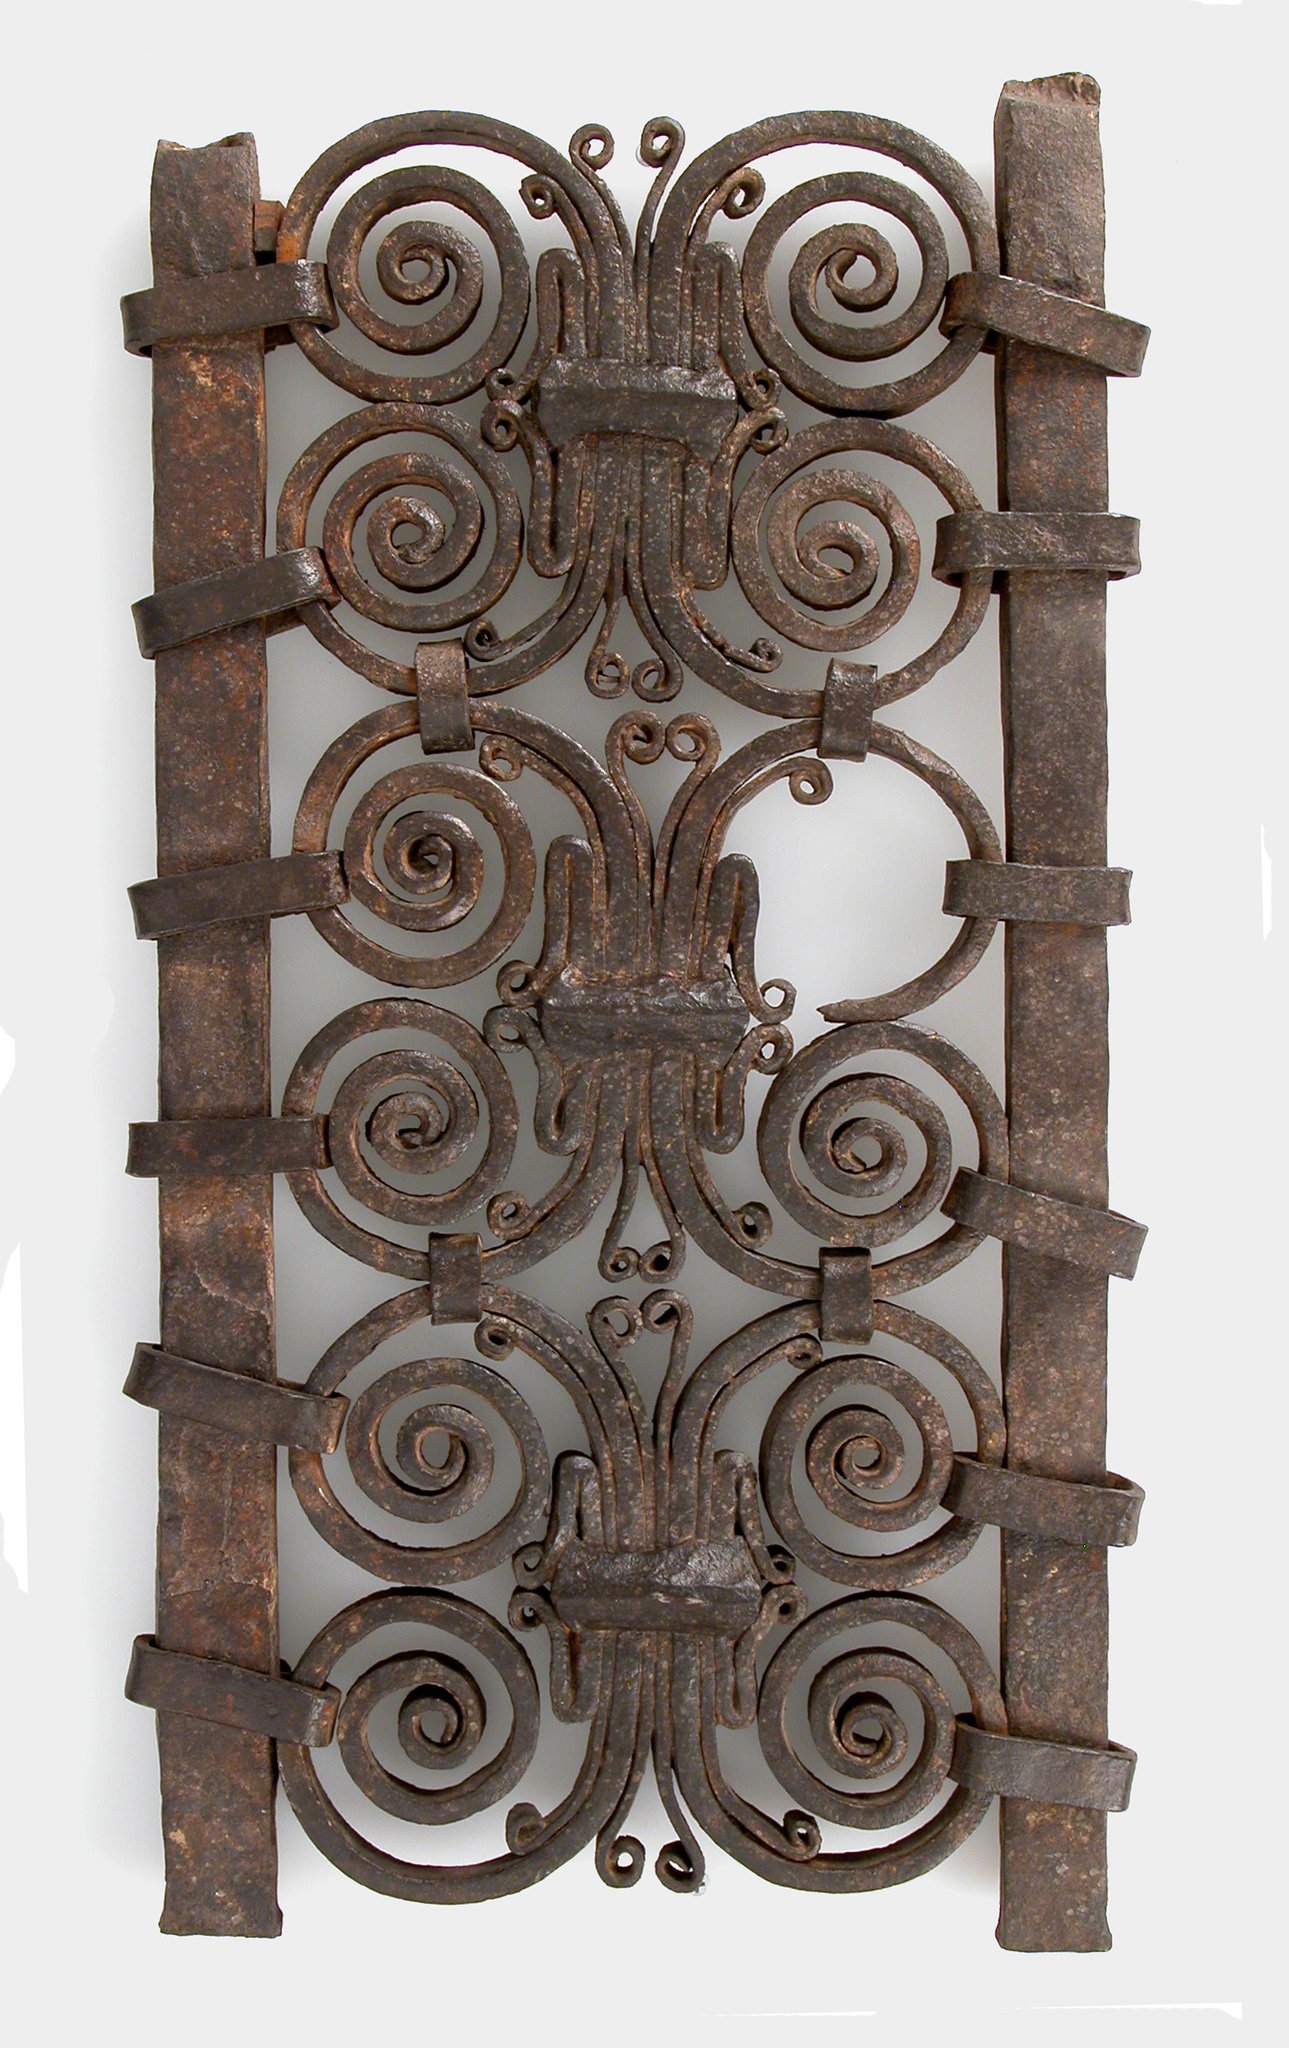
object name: grill portion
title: Grill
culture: spanish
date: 1101-1300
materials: iron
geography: spain